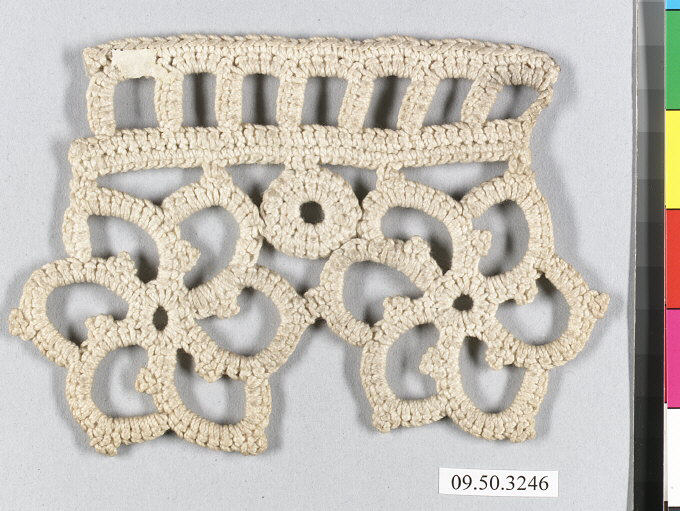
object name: sample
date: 1801-1900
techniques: crochet